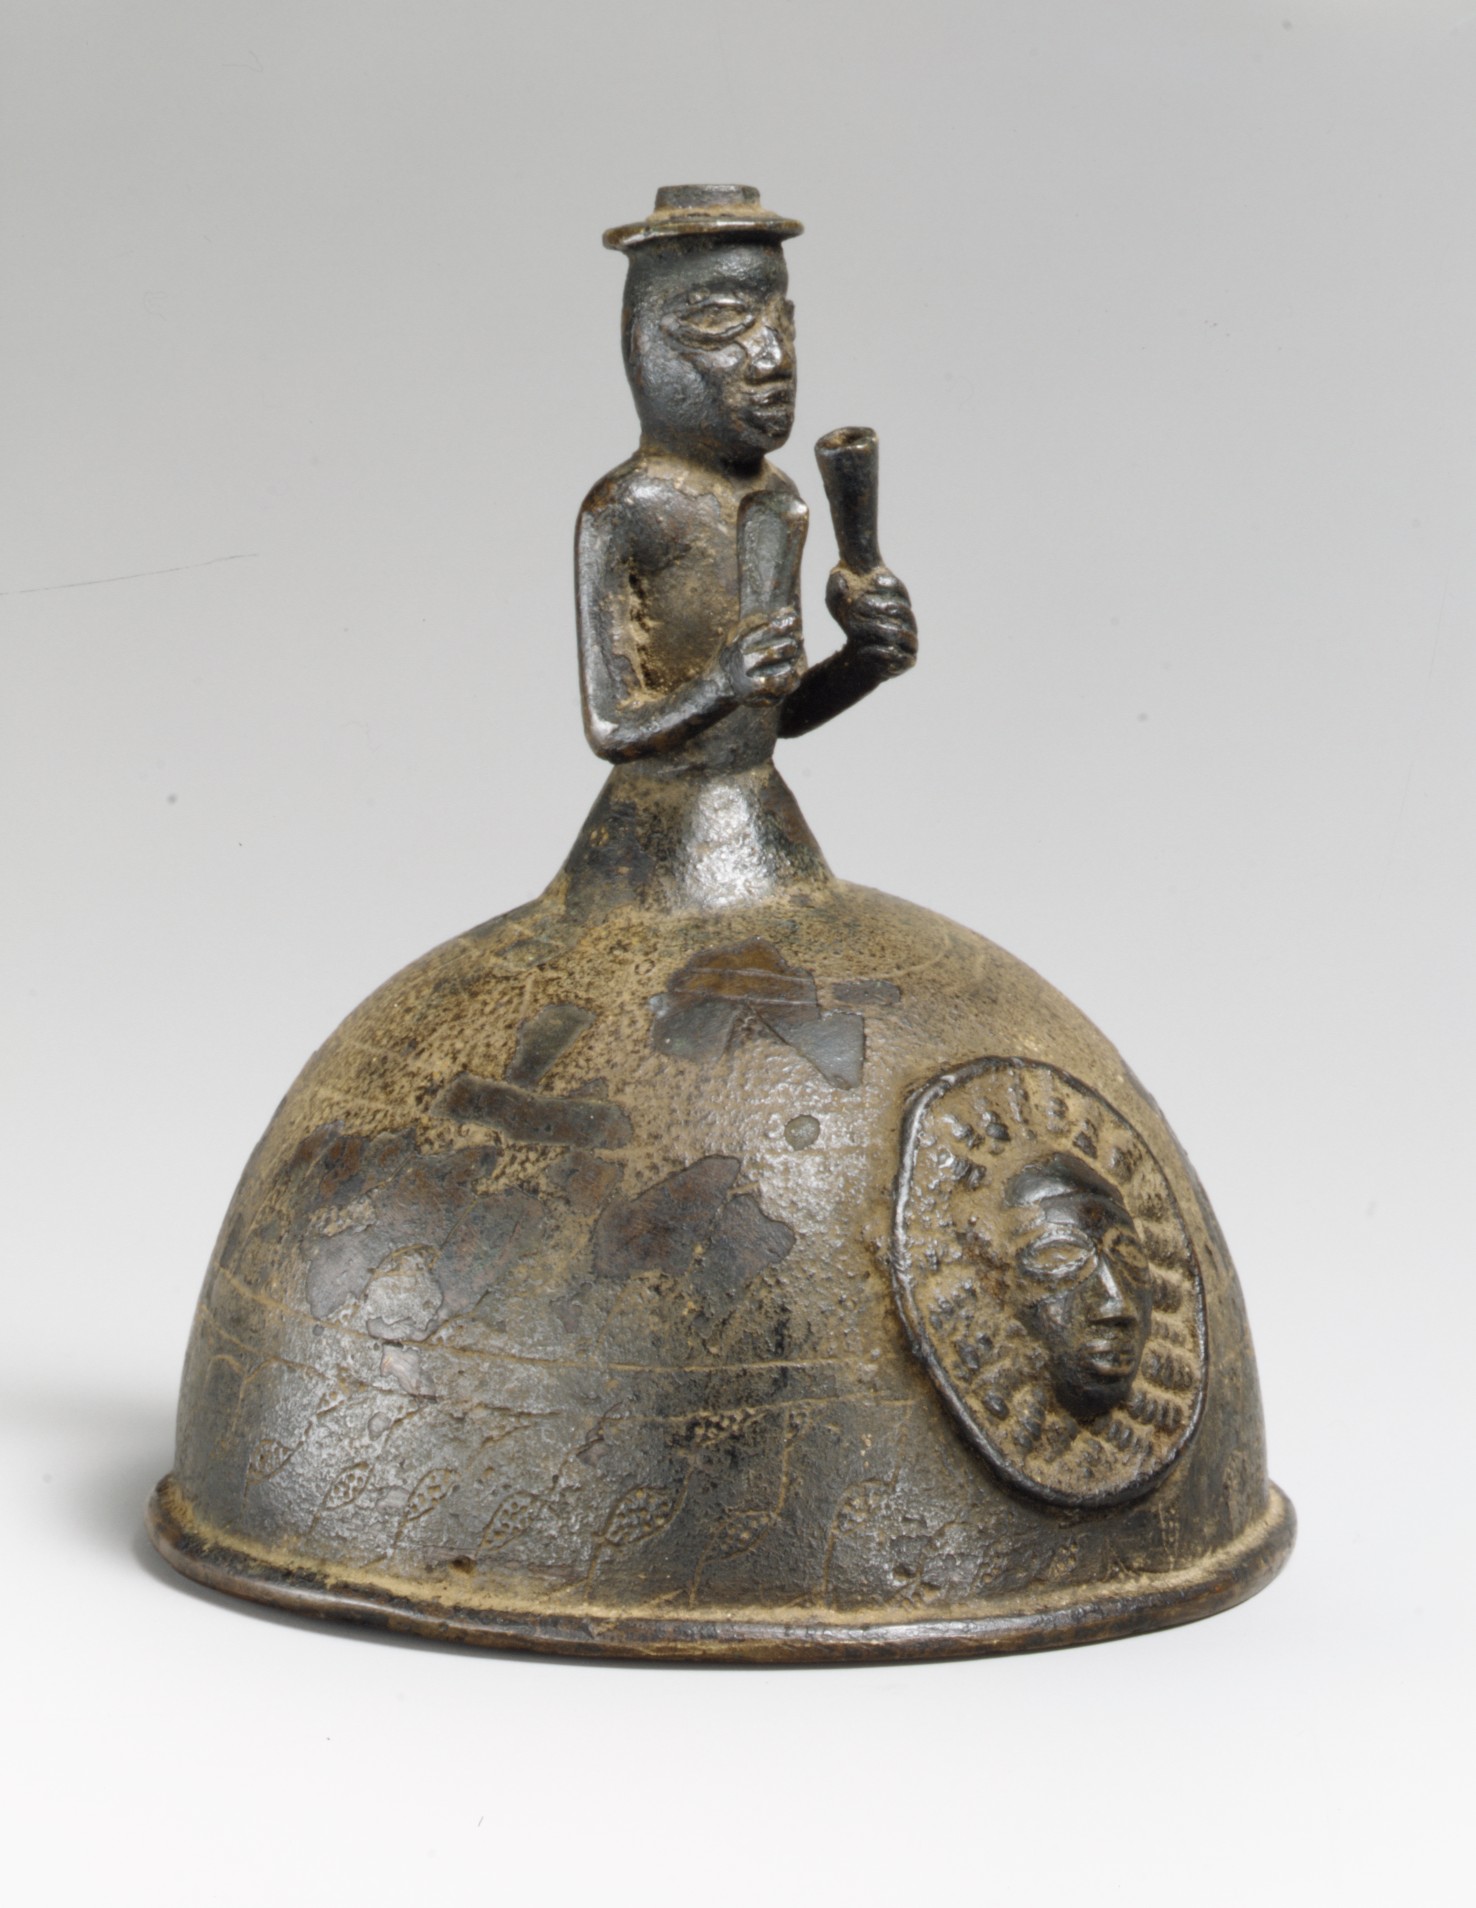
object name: vessel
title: Divination Vessel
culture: edo period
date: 1701-1900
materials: brass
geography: nigeria